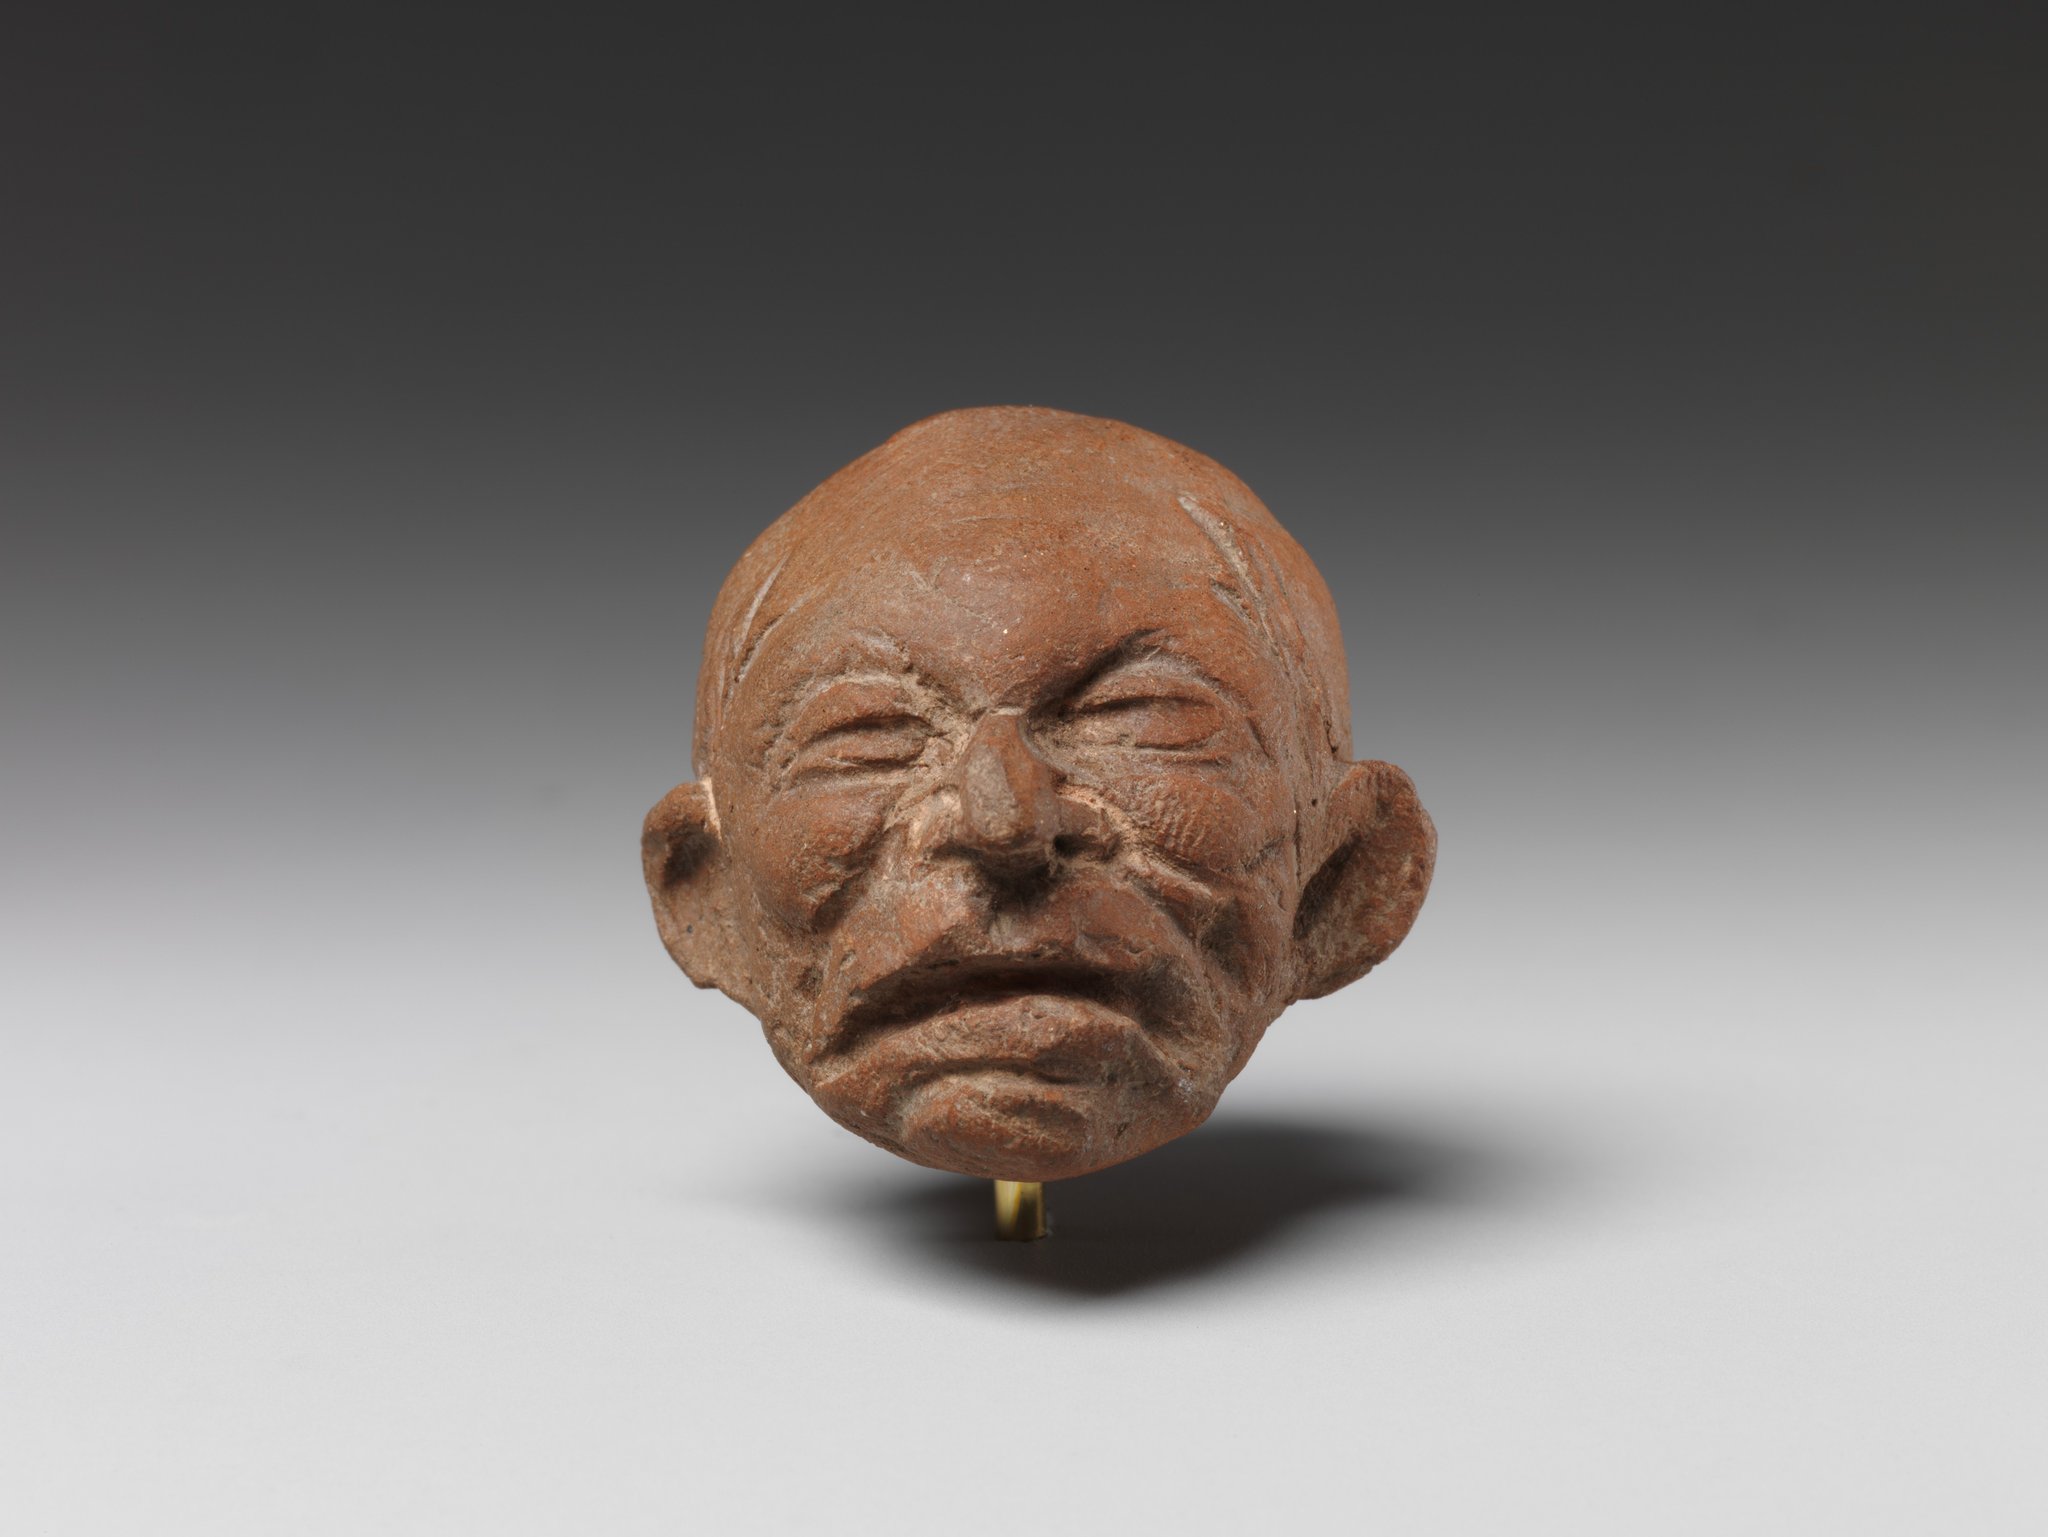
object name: head, old man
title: Head of an old man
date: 200-1 BCE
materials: pottery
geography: memphite region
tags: heads,men